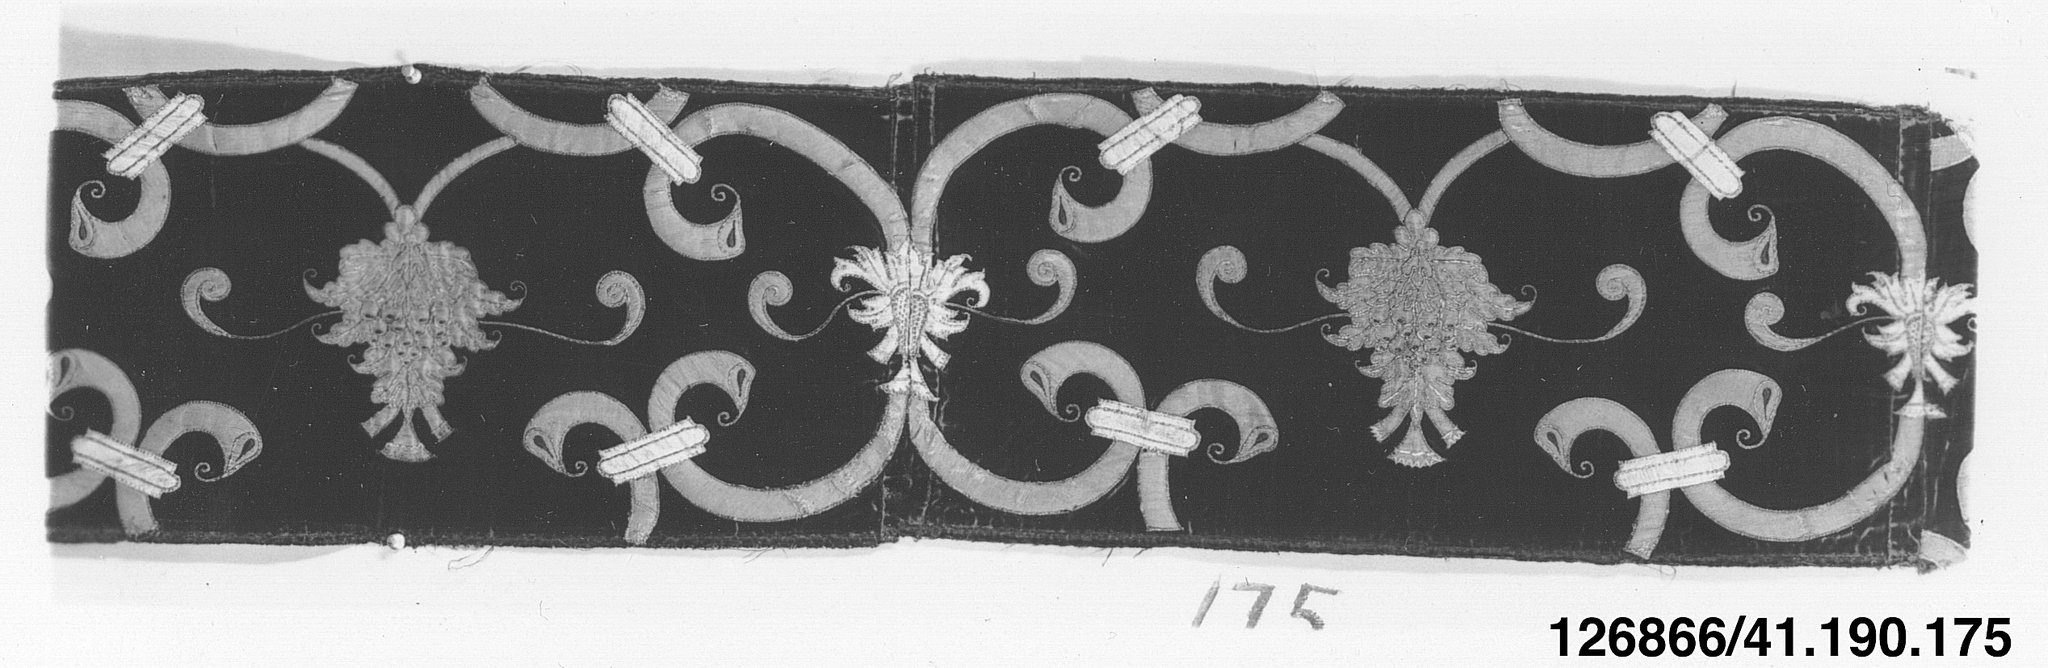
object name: panel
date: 1501-1700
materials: metal thread, silk